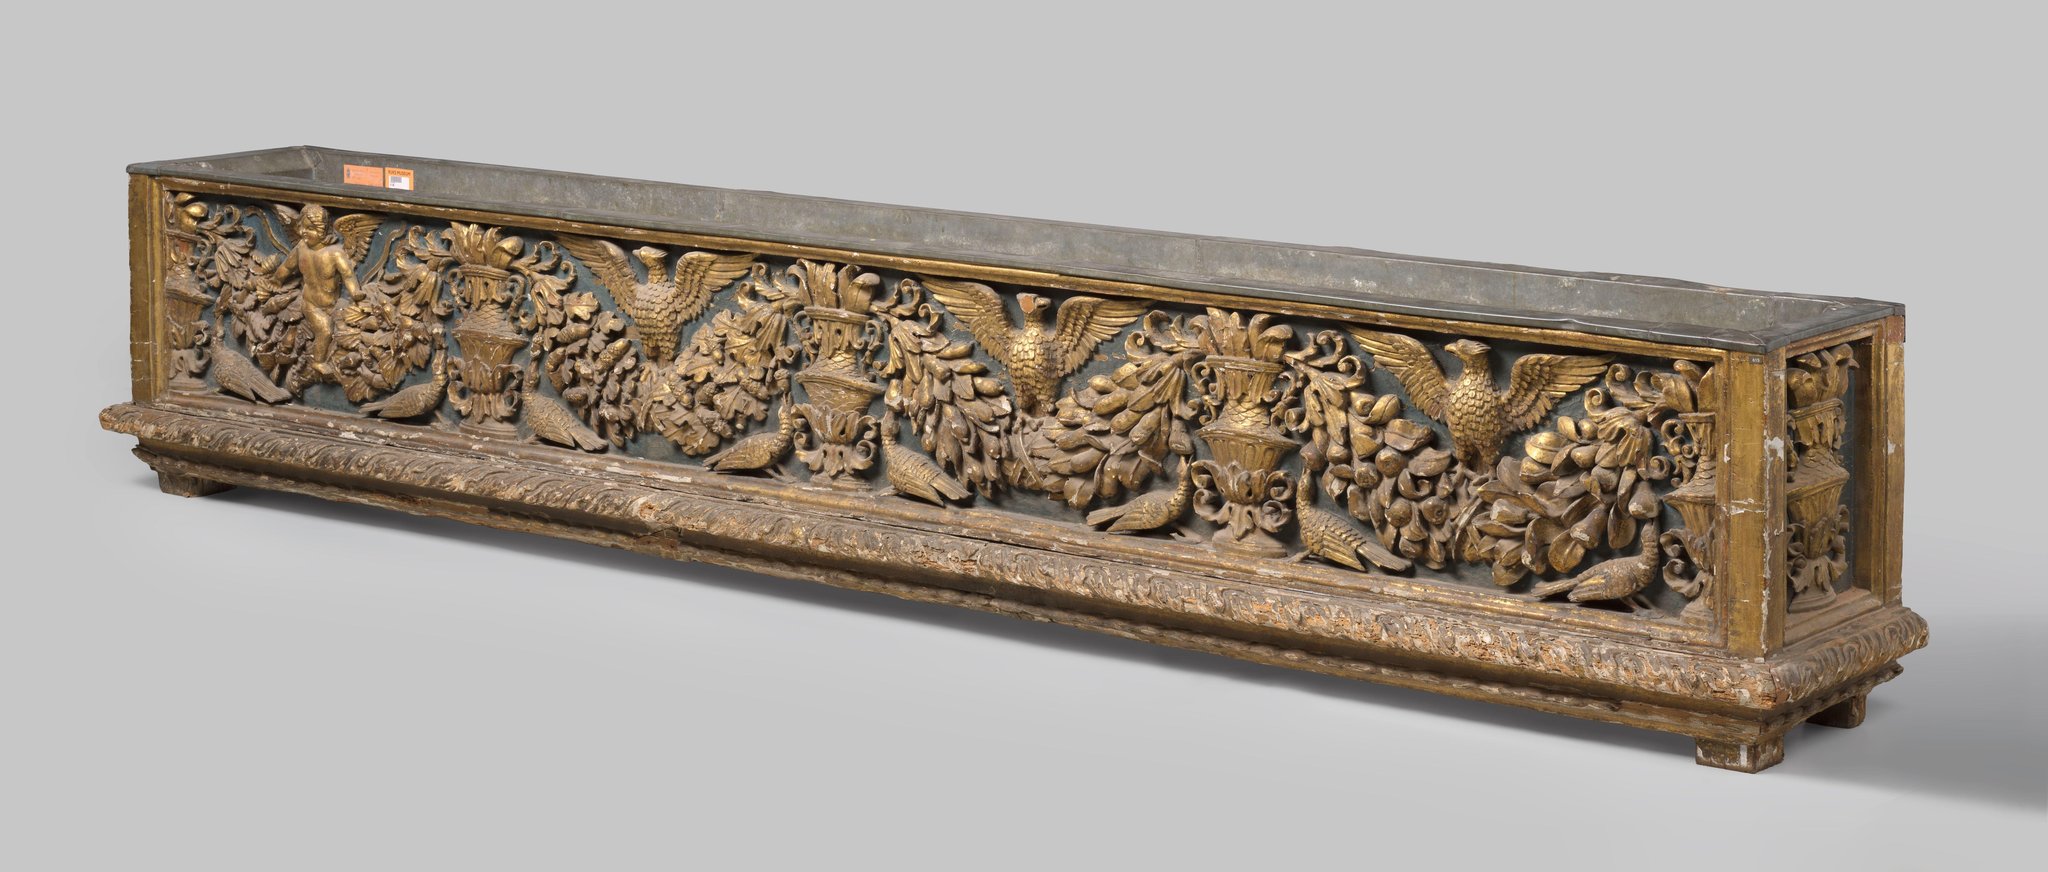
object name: container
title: Rechthoekige bak van verguld hout op een blauw fond, later vermaakt tot bloembak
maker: Anonymous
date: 1500-1600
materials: wood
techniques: gilding, painted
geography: italy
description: Rechthoekige bak van verguld hout op een blauw fond. Aan de voorzijde zijn in gestoken reliëf bladkransen aangebracht, waarop adelaars met gespreide vleugels en links een zittende putto. De bloemkransen zijn bevestigd aan gestileerde vazen, die door vogels geflankeerd worden. De zijkanten vertonen eveneens vazen. De bak is in latere tijd tot bloembak vermaakt.